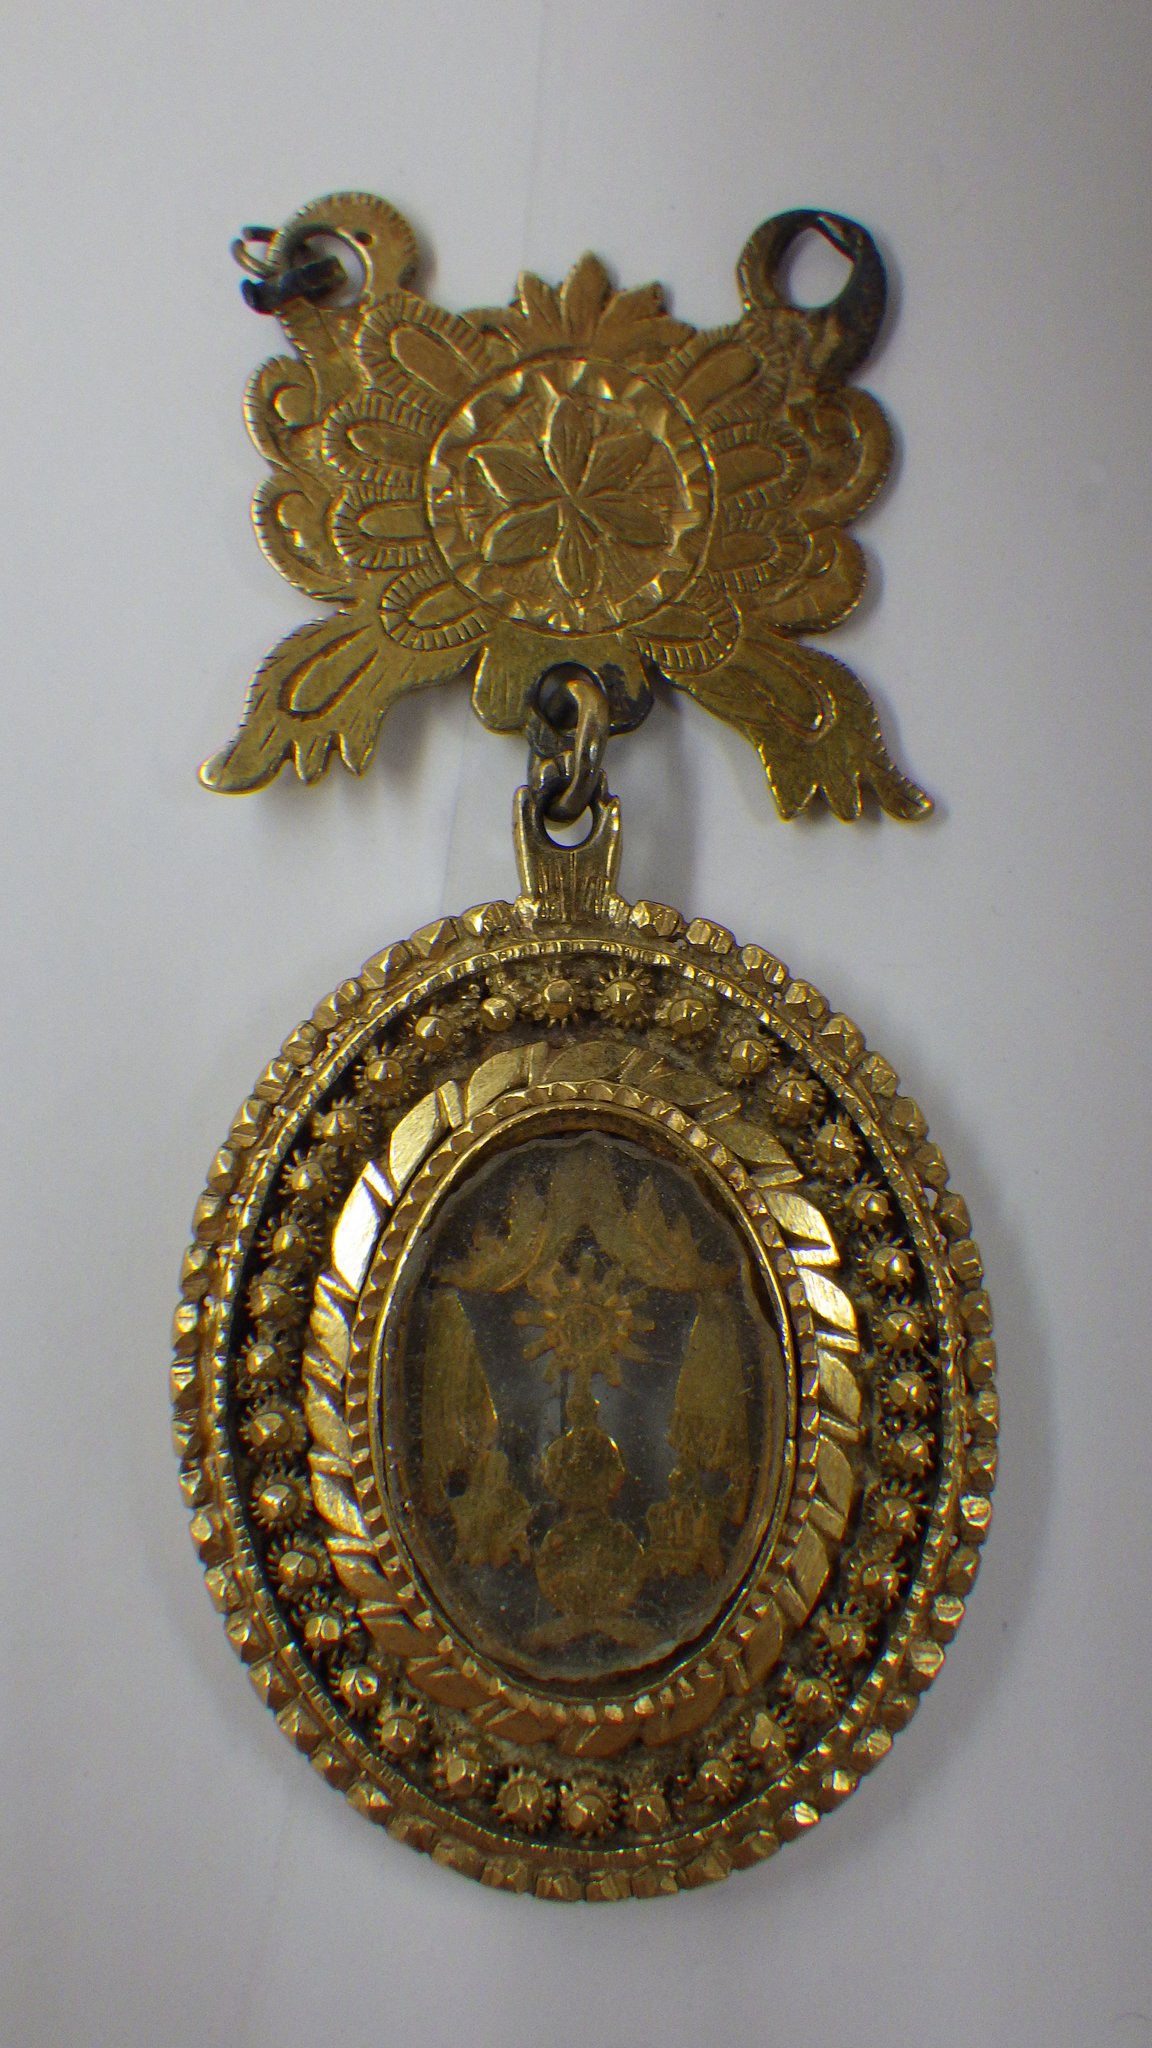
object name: pendant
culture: filipino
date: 1701-1900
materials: alloy, glass, gold